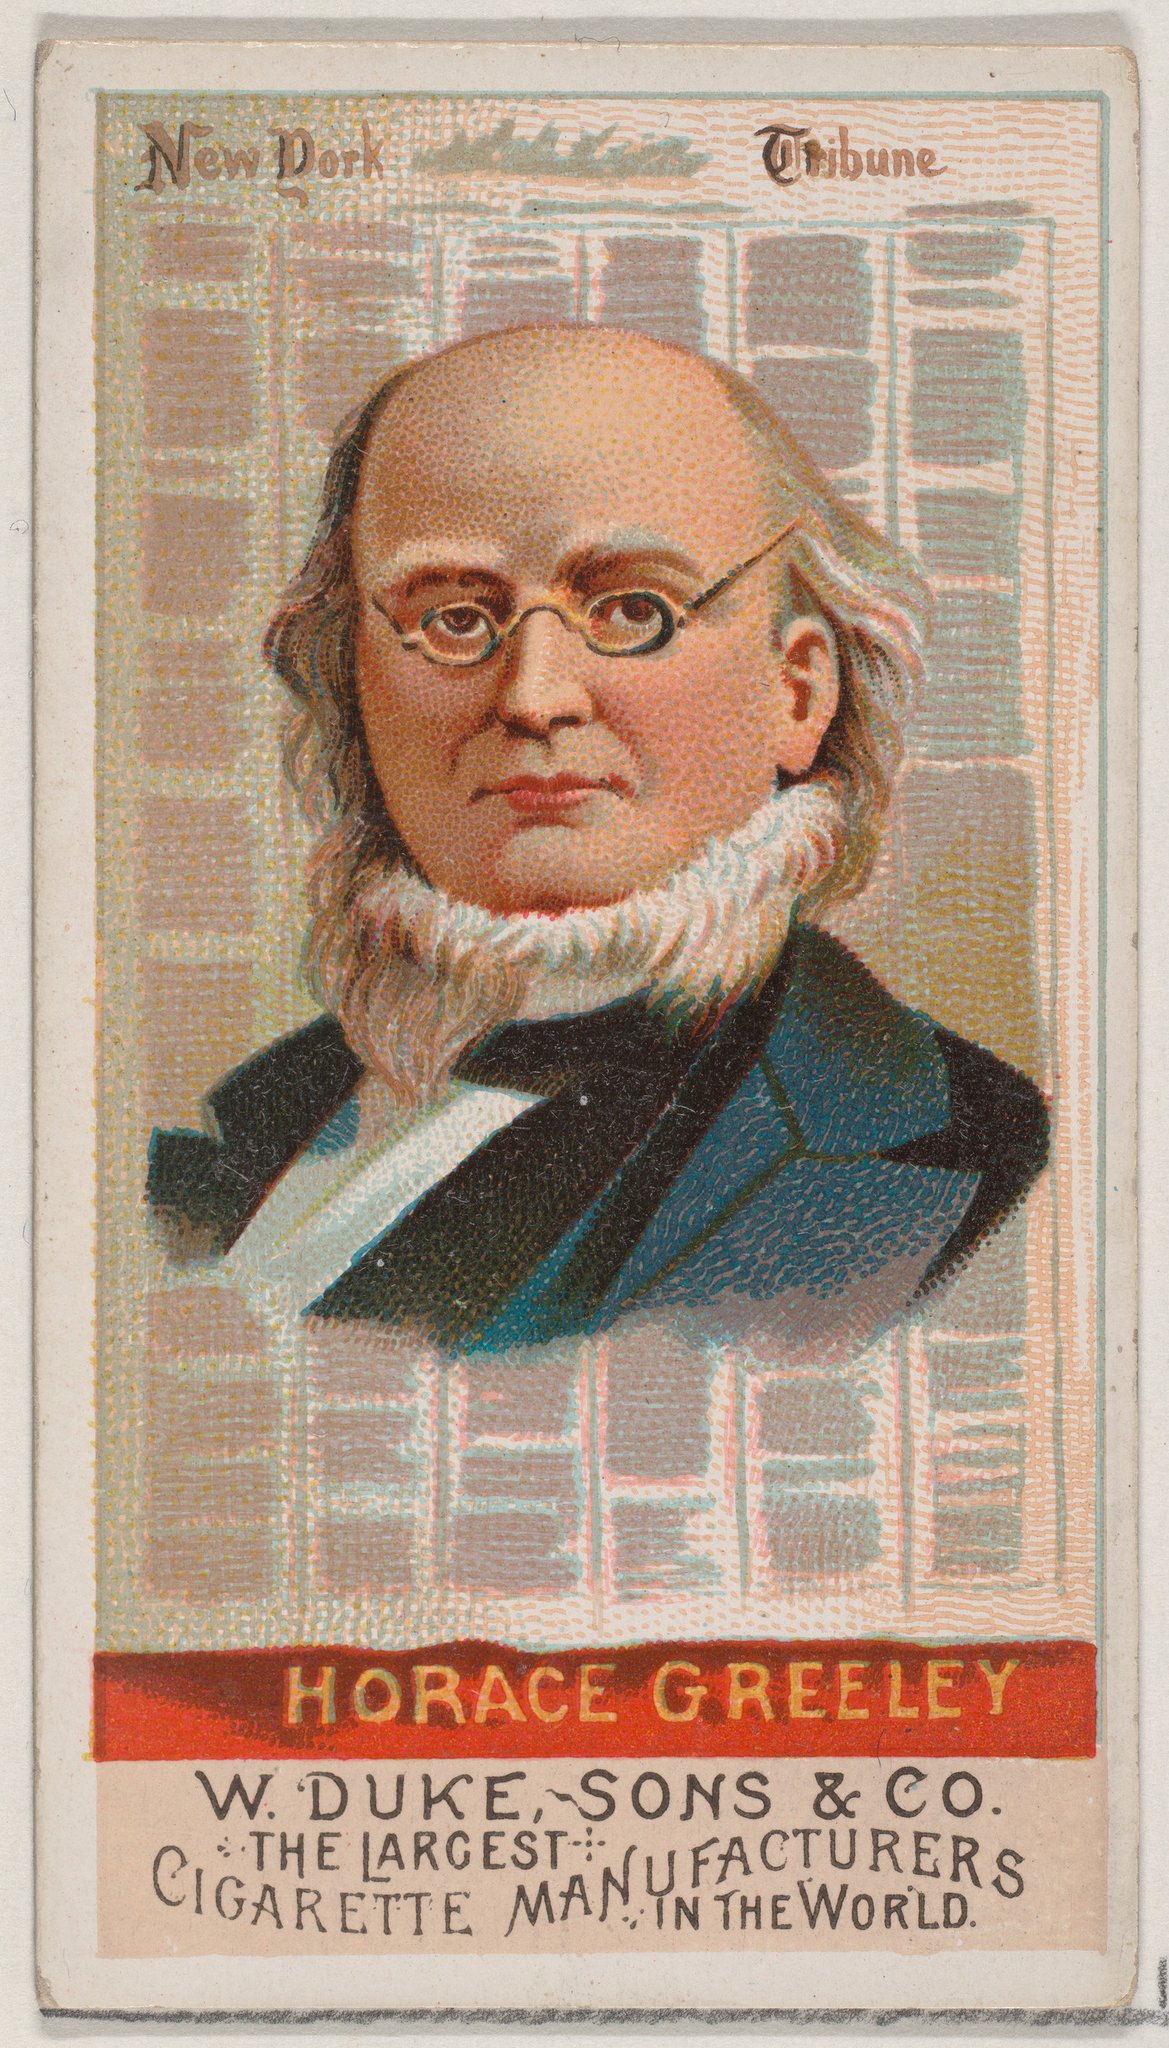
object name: print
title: Horace Greeley, from the series Great Americans (N76) for Duke brand cigarettes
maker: w. duke, sons & co.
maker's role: publisher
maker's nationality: american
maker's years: 1870-1920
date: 1888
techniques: color lithograph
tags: men